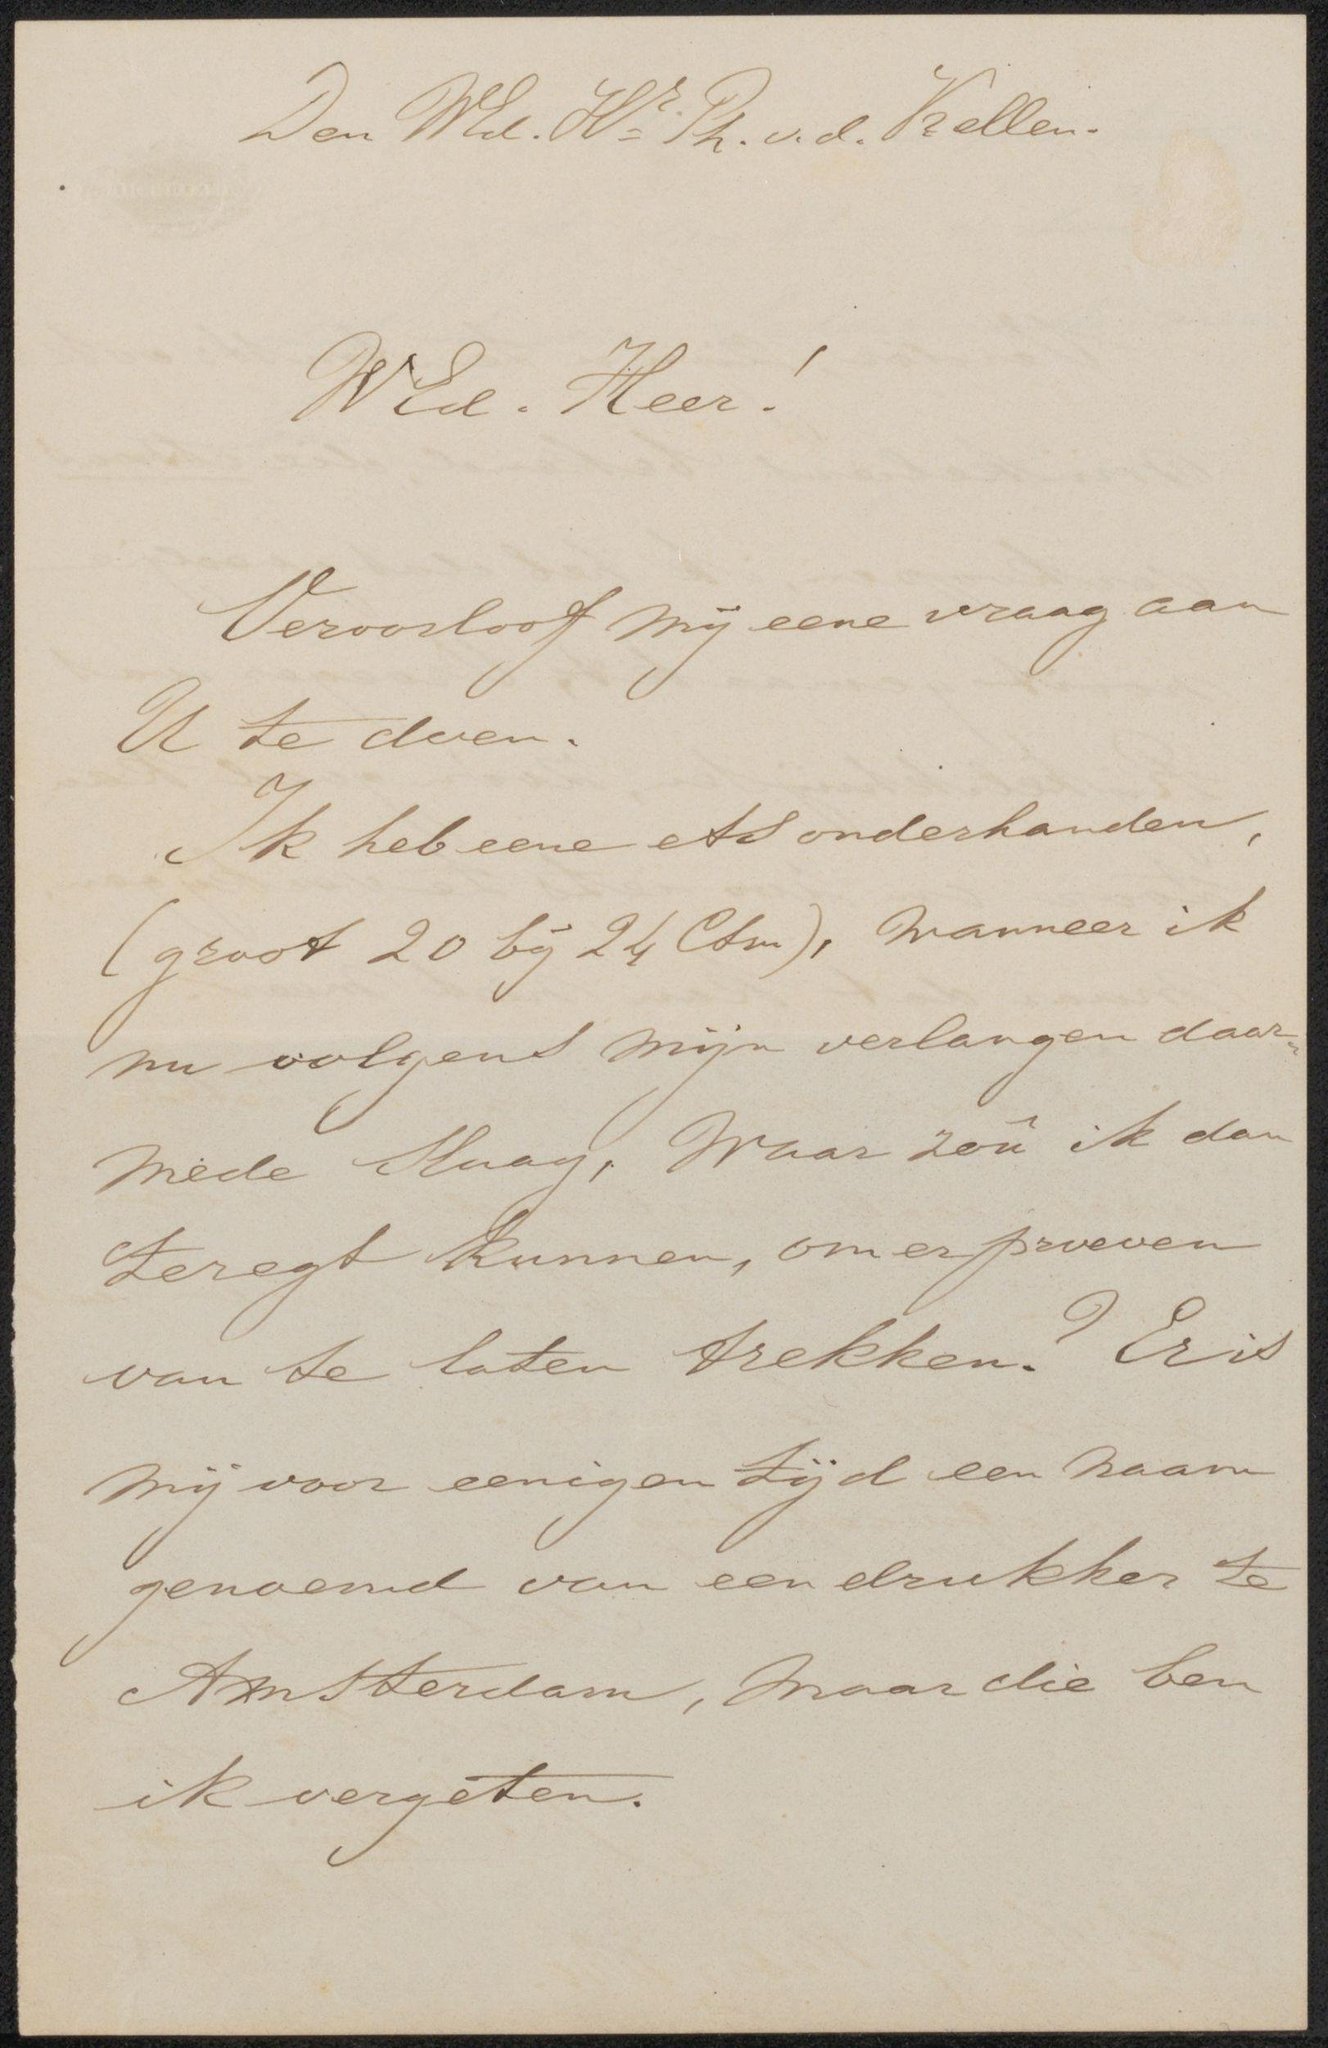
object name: letter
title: Brief aan Johan Philip van der Kellen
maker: johannes everhardus rijnboutt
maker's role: print maker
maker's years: 1839-1900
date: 1890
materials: ink, paper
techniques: pen, writing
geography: asten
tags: print maker, draughtsman, johan philip van der kellen, painter, hermanus jan hendrik rijkelijkhuizen, the graphic arts, the hague, amsterdam